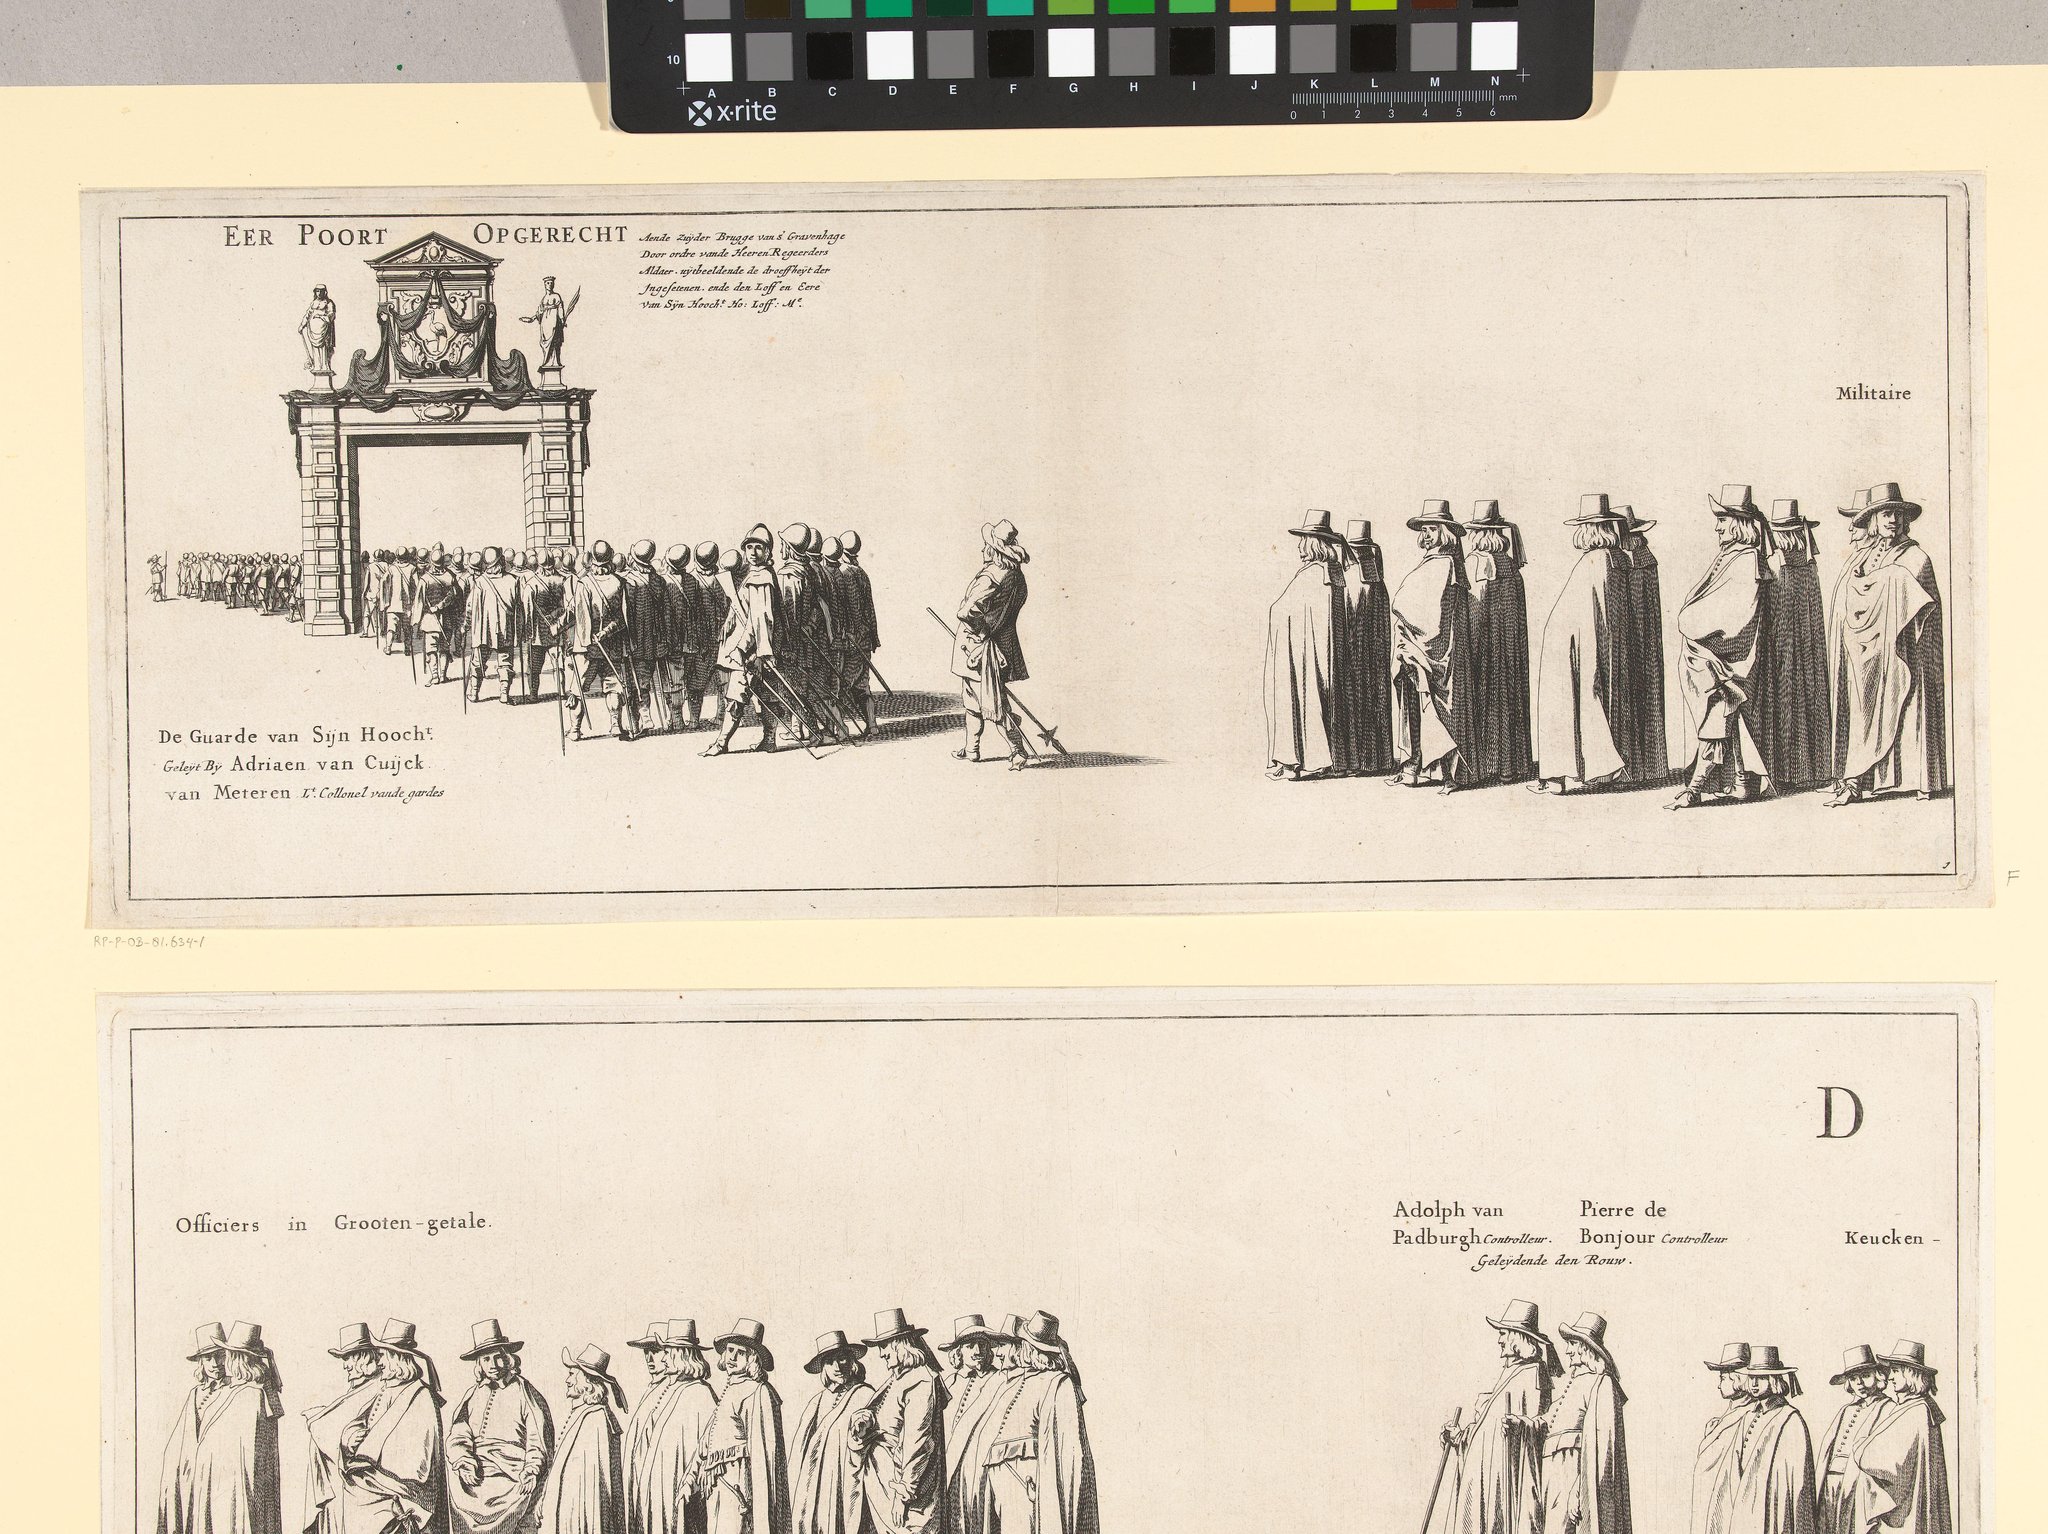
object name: print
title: De begrafenisstoet van Frederik Hendrik (plaat nr. 1), 1647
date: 1647-1651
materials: paper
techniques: etching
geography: amsterdam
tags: delft, frederick henry (prince of orange), cortege, funeral procession, the hague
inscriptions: collector's mark, collector's mark: Lugt 963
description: De begrafenisstoet van stadhouder Frederik Hendrik te 's-Gravenhage op 10 mei 1647. Plaat nr. 1 met het voorste deel van de stoet dat door een erepoort trekt. Onderdeel van een serie van 30 platen en 20 tekstbladen, bedoeld om aan elkaar geplakt te worden.